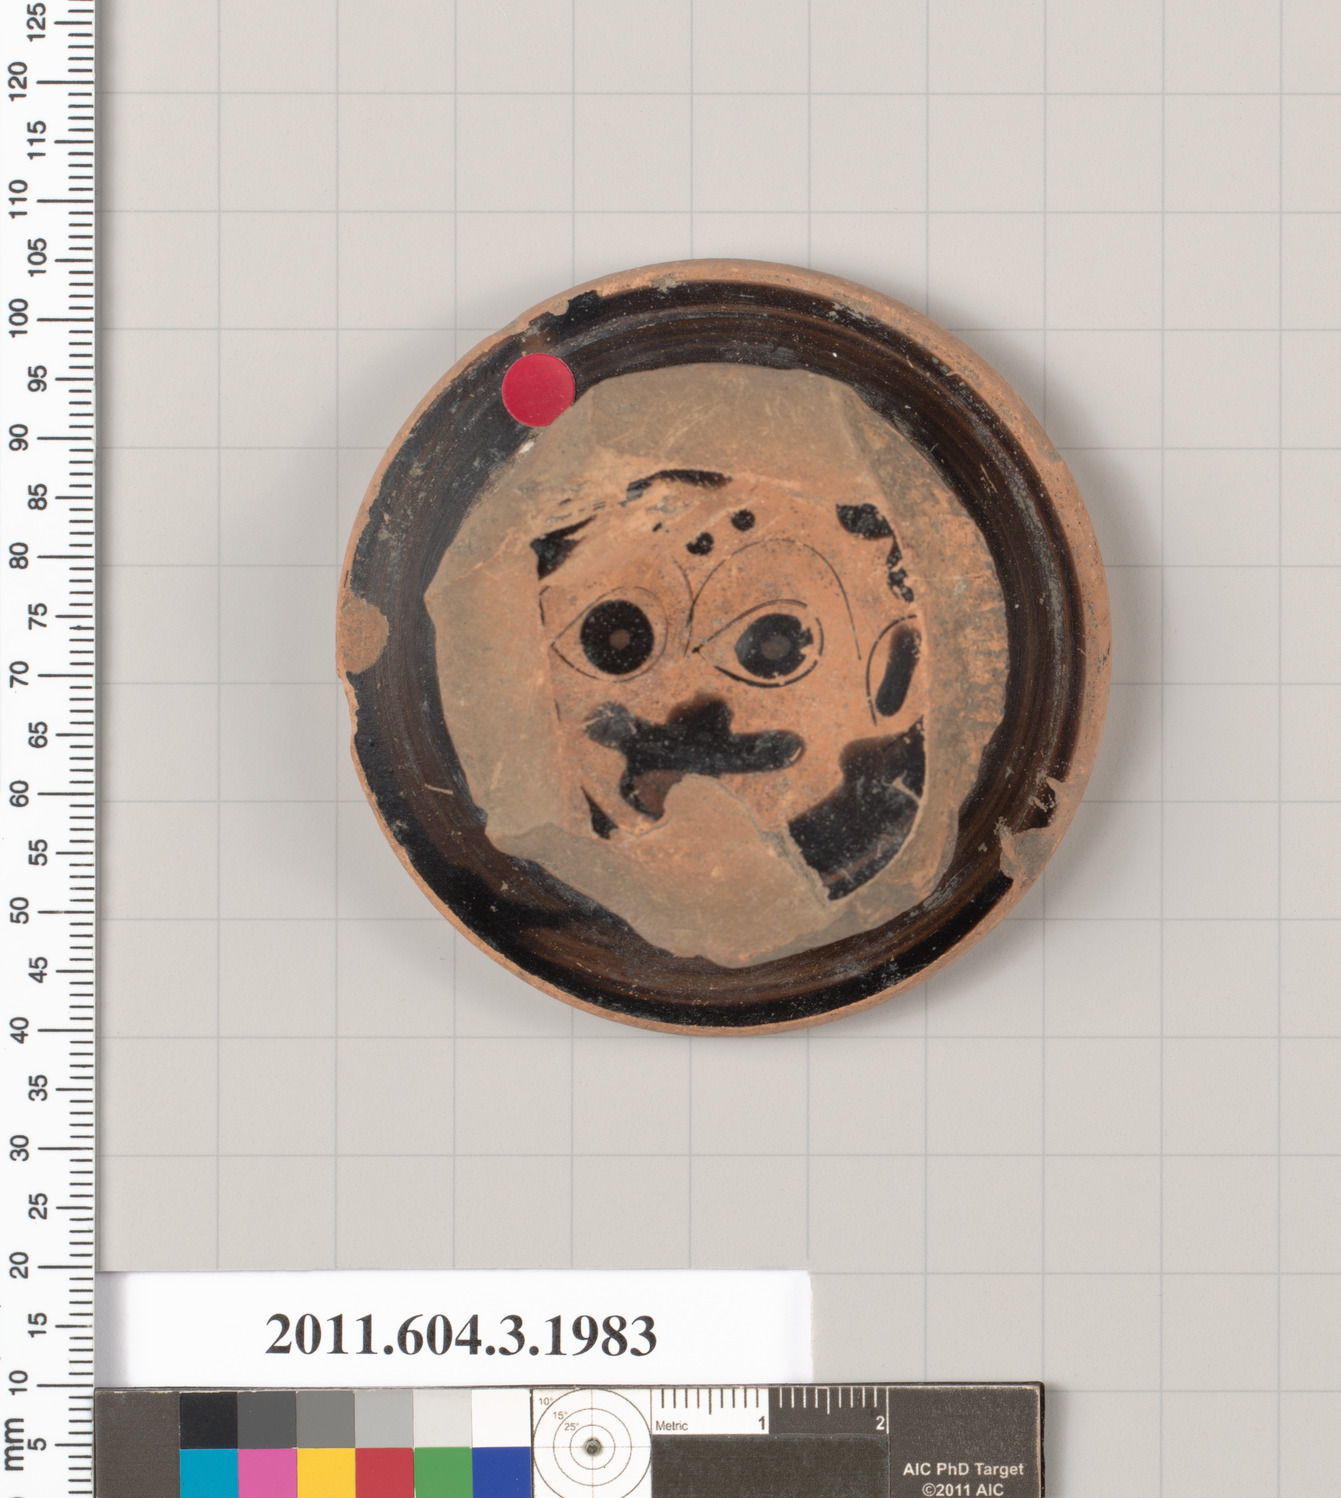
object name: kylix fragment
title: Terracotta fragment of a stemless cup (drinking cup)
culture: greek, attic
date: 550-526 BCE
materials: terracotta